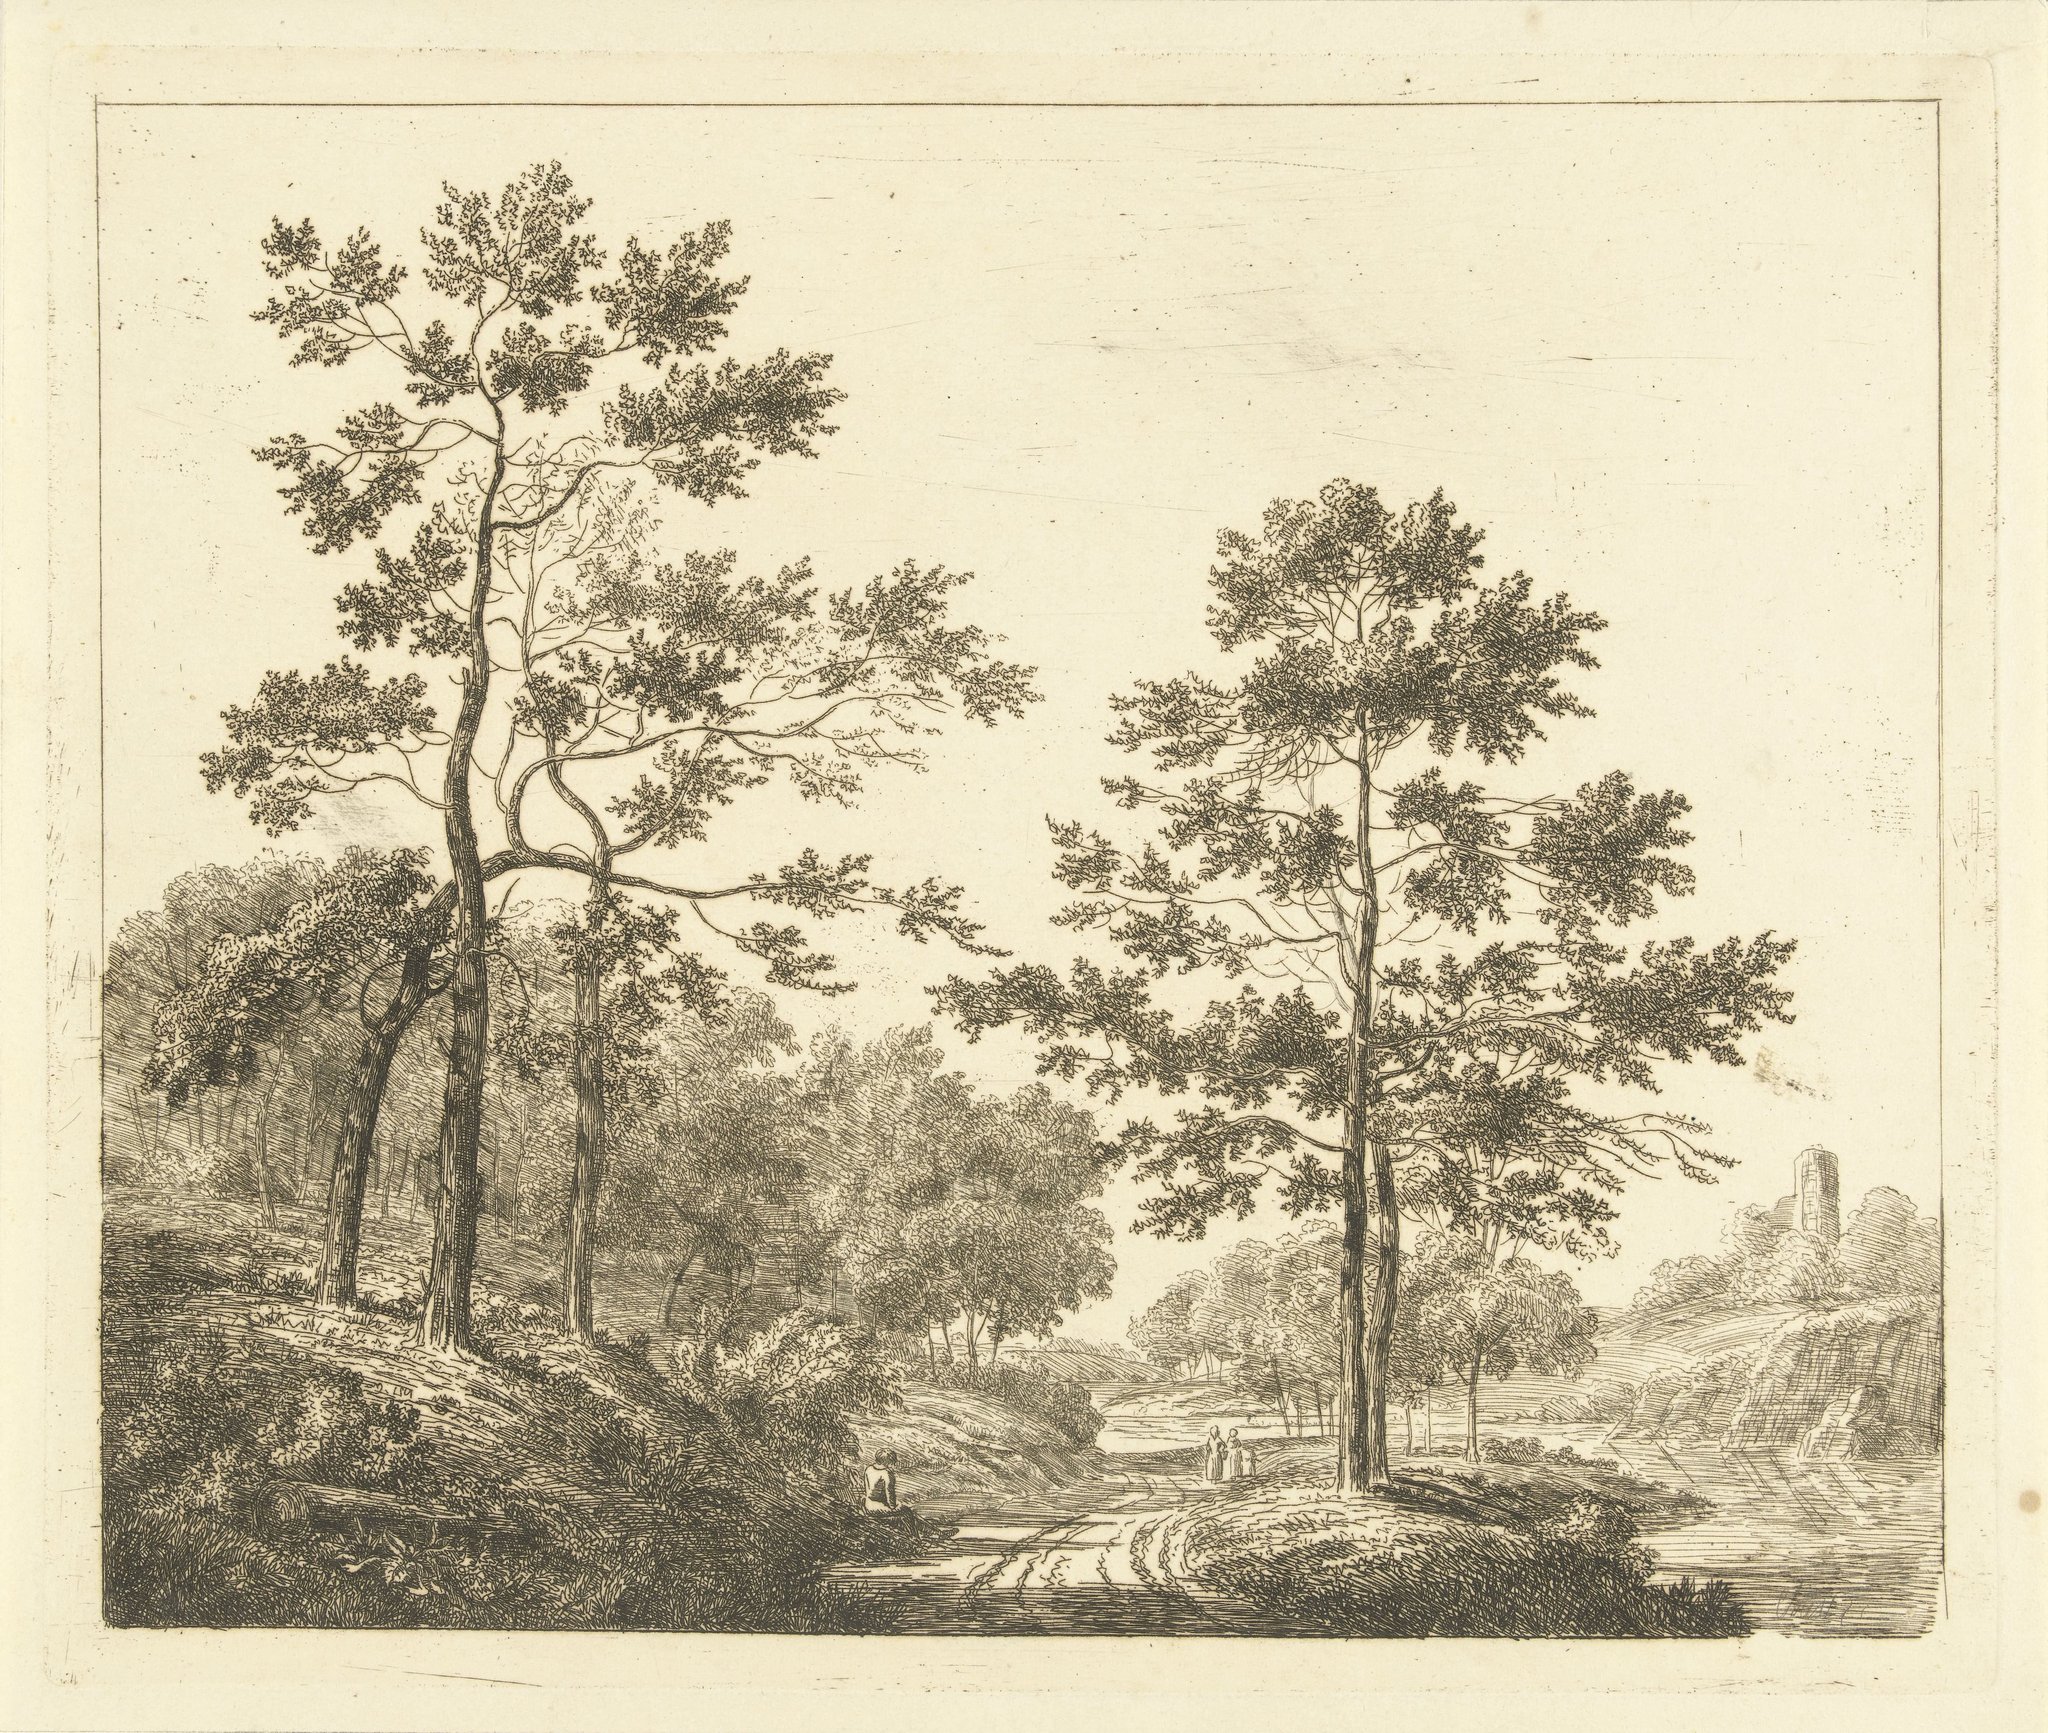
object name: print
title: De weg langs de heuvels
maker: johannes franciscus christ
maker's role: draughtsman, print maker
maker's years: 1790-1845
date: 1810-1830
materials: paper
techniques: etching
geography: nijmegen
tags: forest path or lane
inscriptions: collector's mark: Lugt 2228